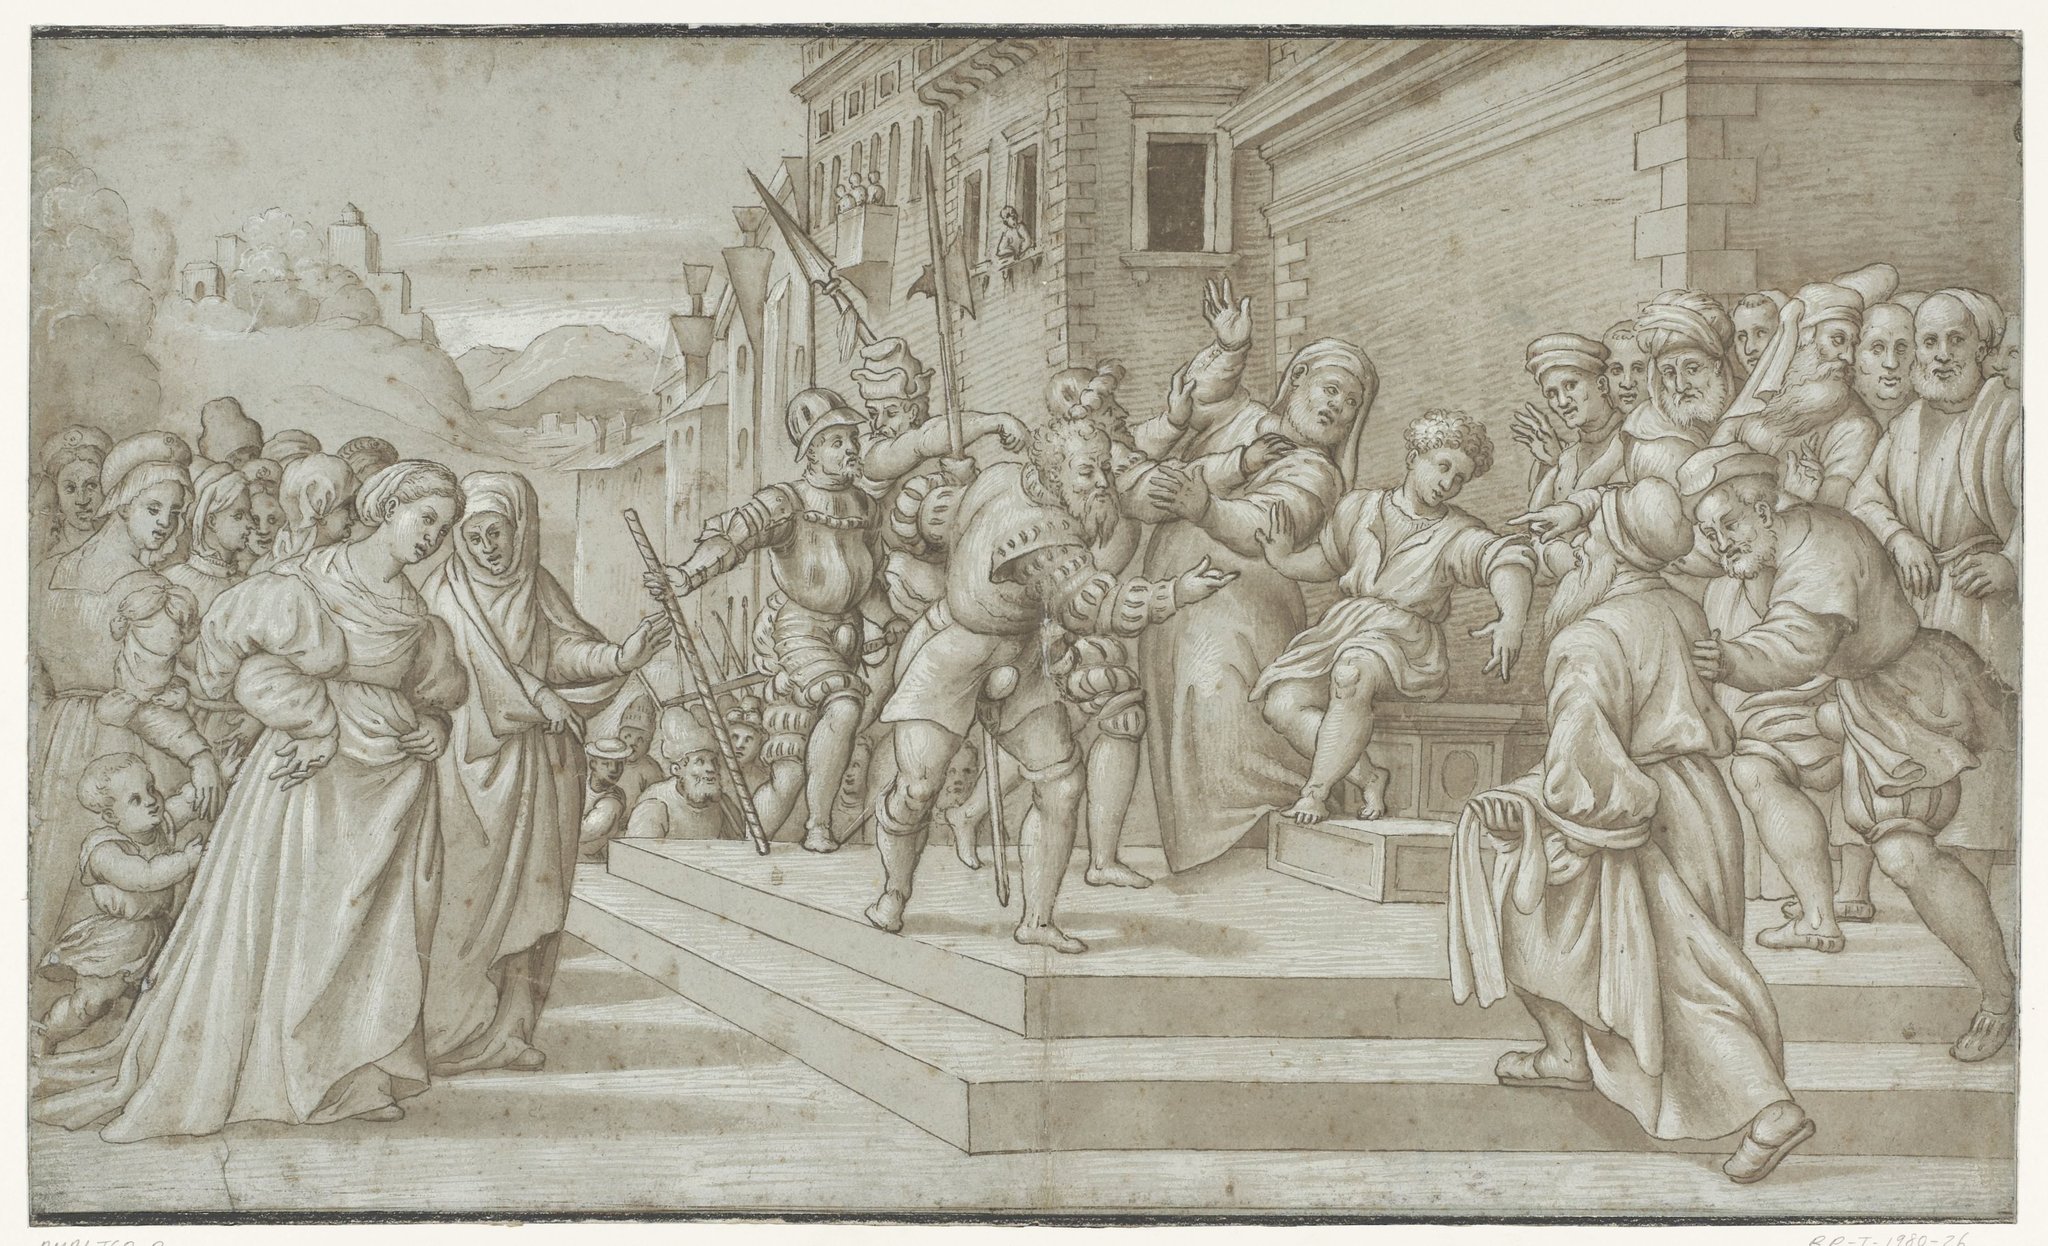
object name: drawing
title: Rechtspraak van Daniël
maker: Anonymous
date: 1525-1600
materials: ink, paper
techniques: brush, pen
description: Kopie naar een verloren ontwerp voor één van de drie fresco's in het stadhuis van Ceneda: de rechtspraak van Daniël.